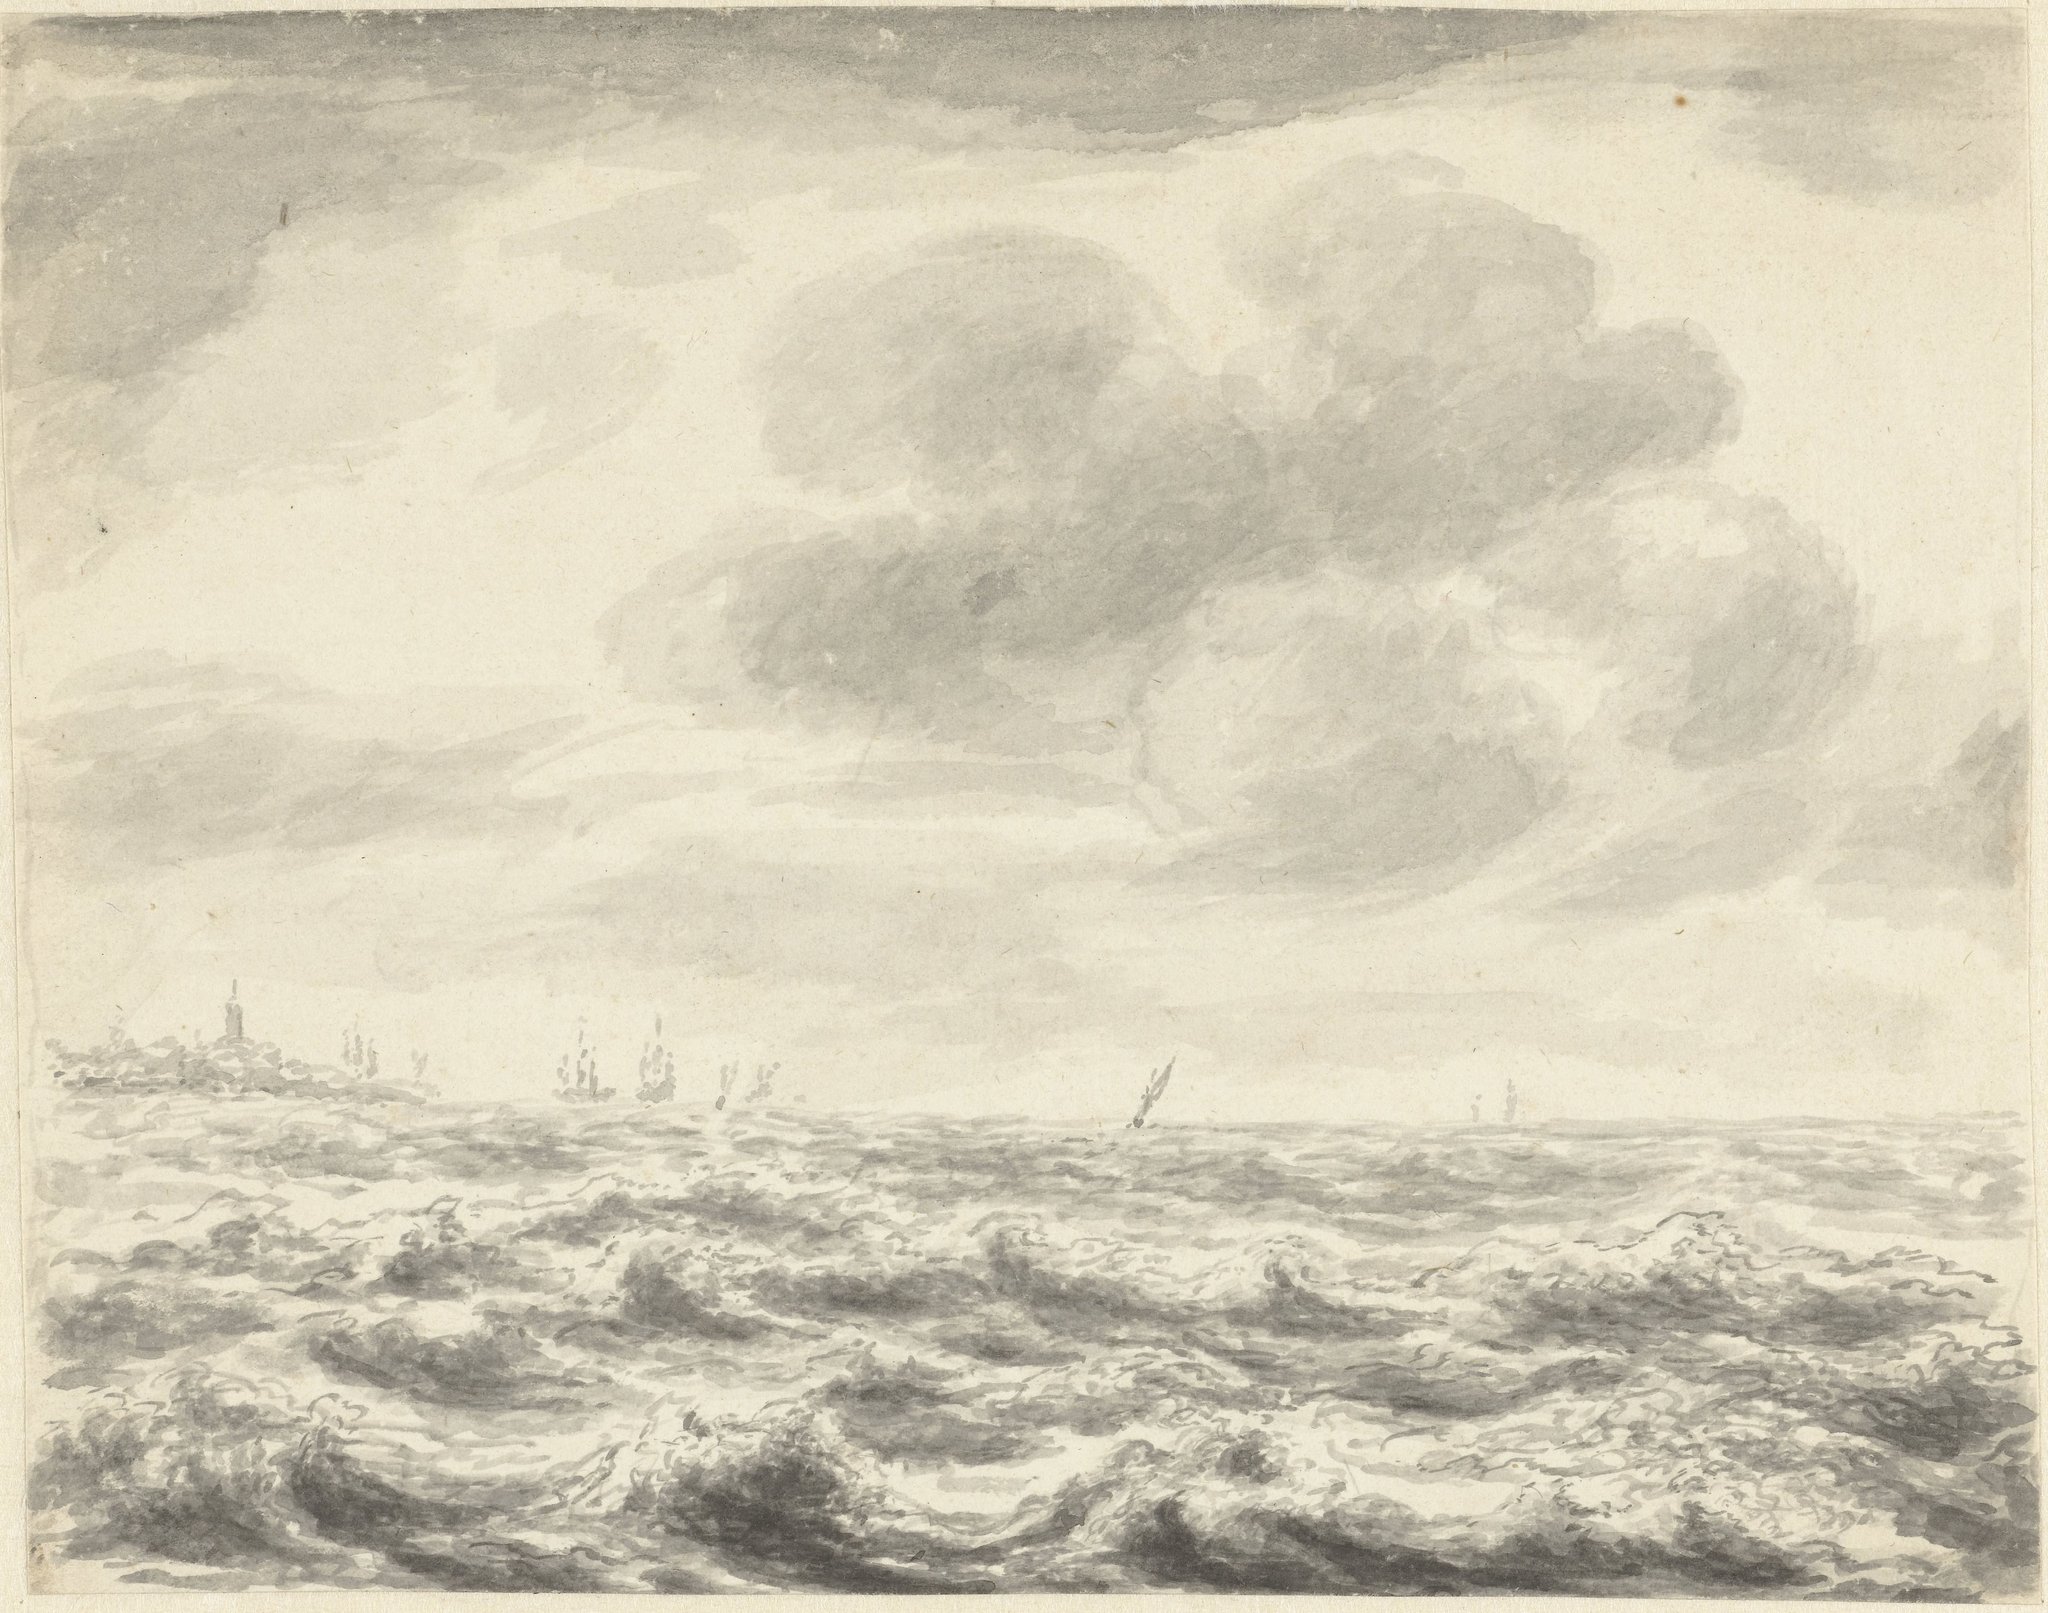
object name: drawing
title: Zeegezicht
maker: pieter idserts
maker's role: draughtsman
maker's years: 1698-1781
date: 1708-1781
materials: paper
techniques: brush